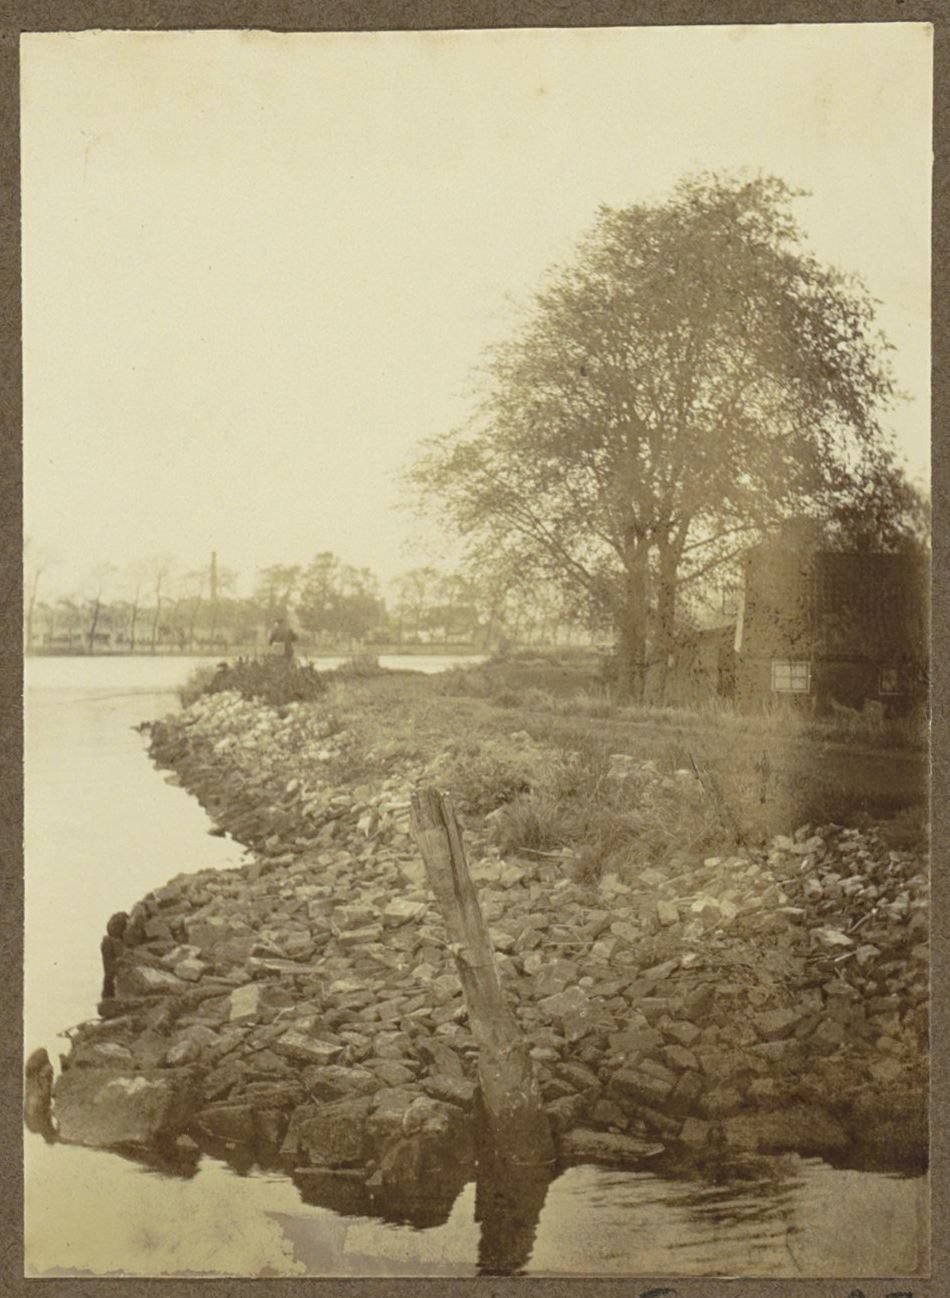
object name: photograph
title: Gezicht op een oever met bebouwing aan de Amstel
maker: Anonymous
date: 1910-1930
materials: paper, photographic support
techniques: daylight paper print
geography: north holland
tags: river bank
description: Onderdeel van Album met foto's van Amsterdam en omgeving.